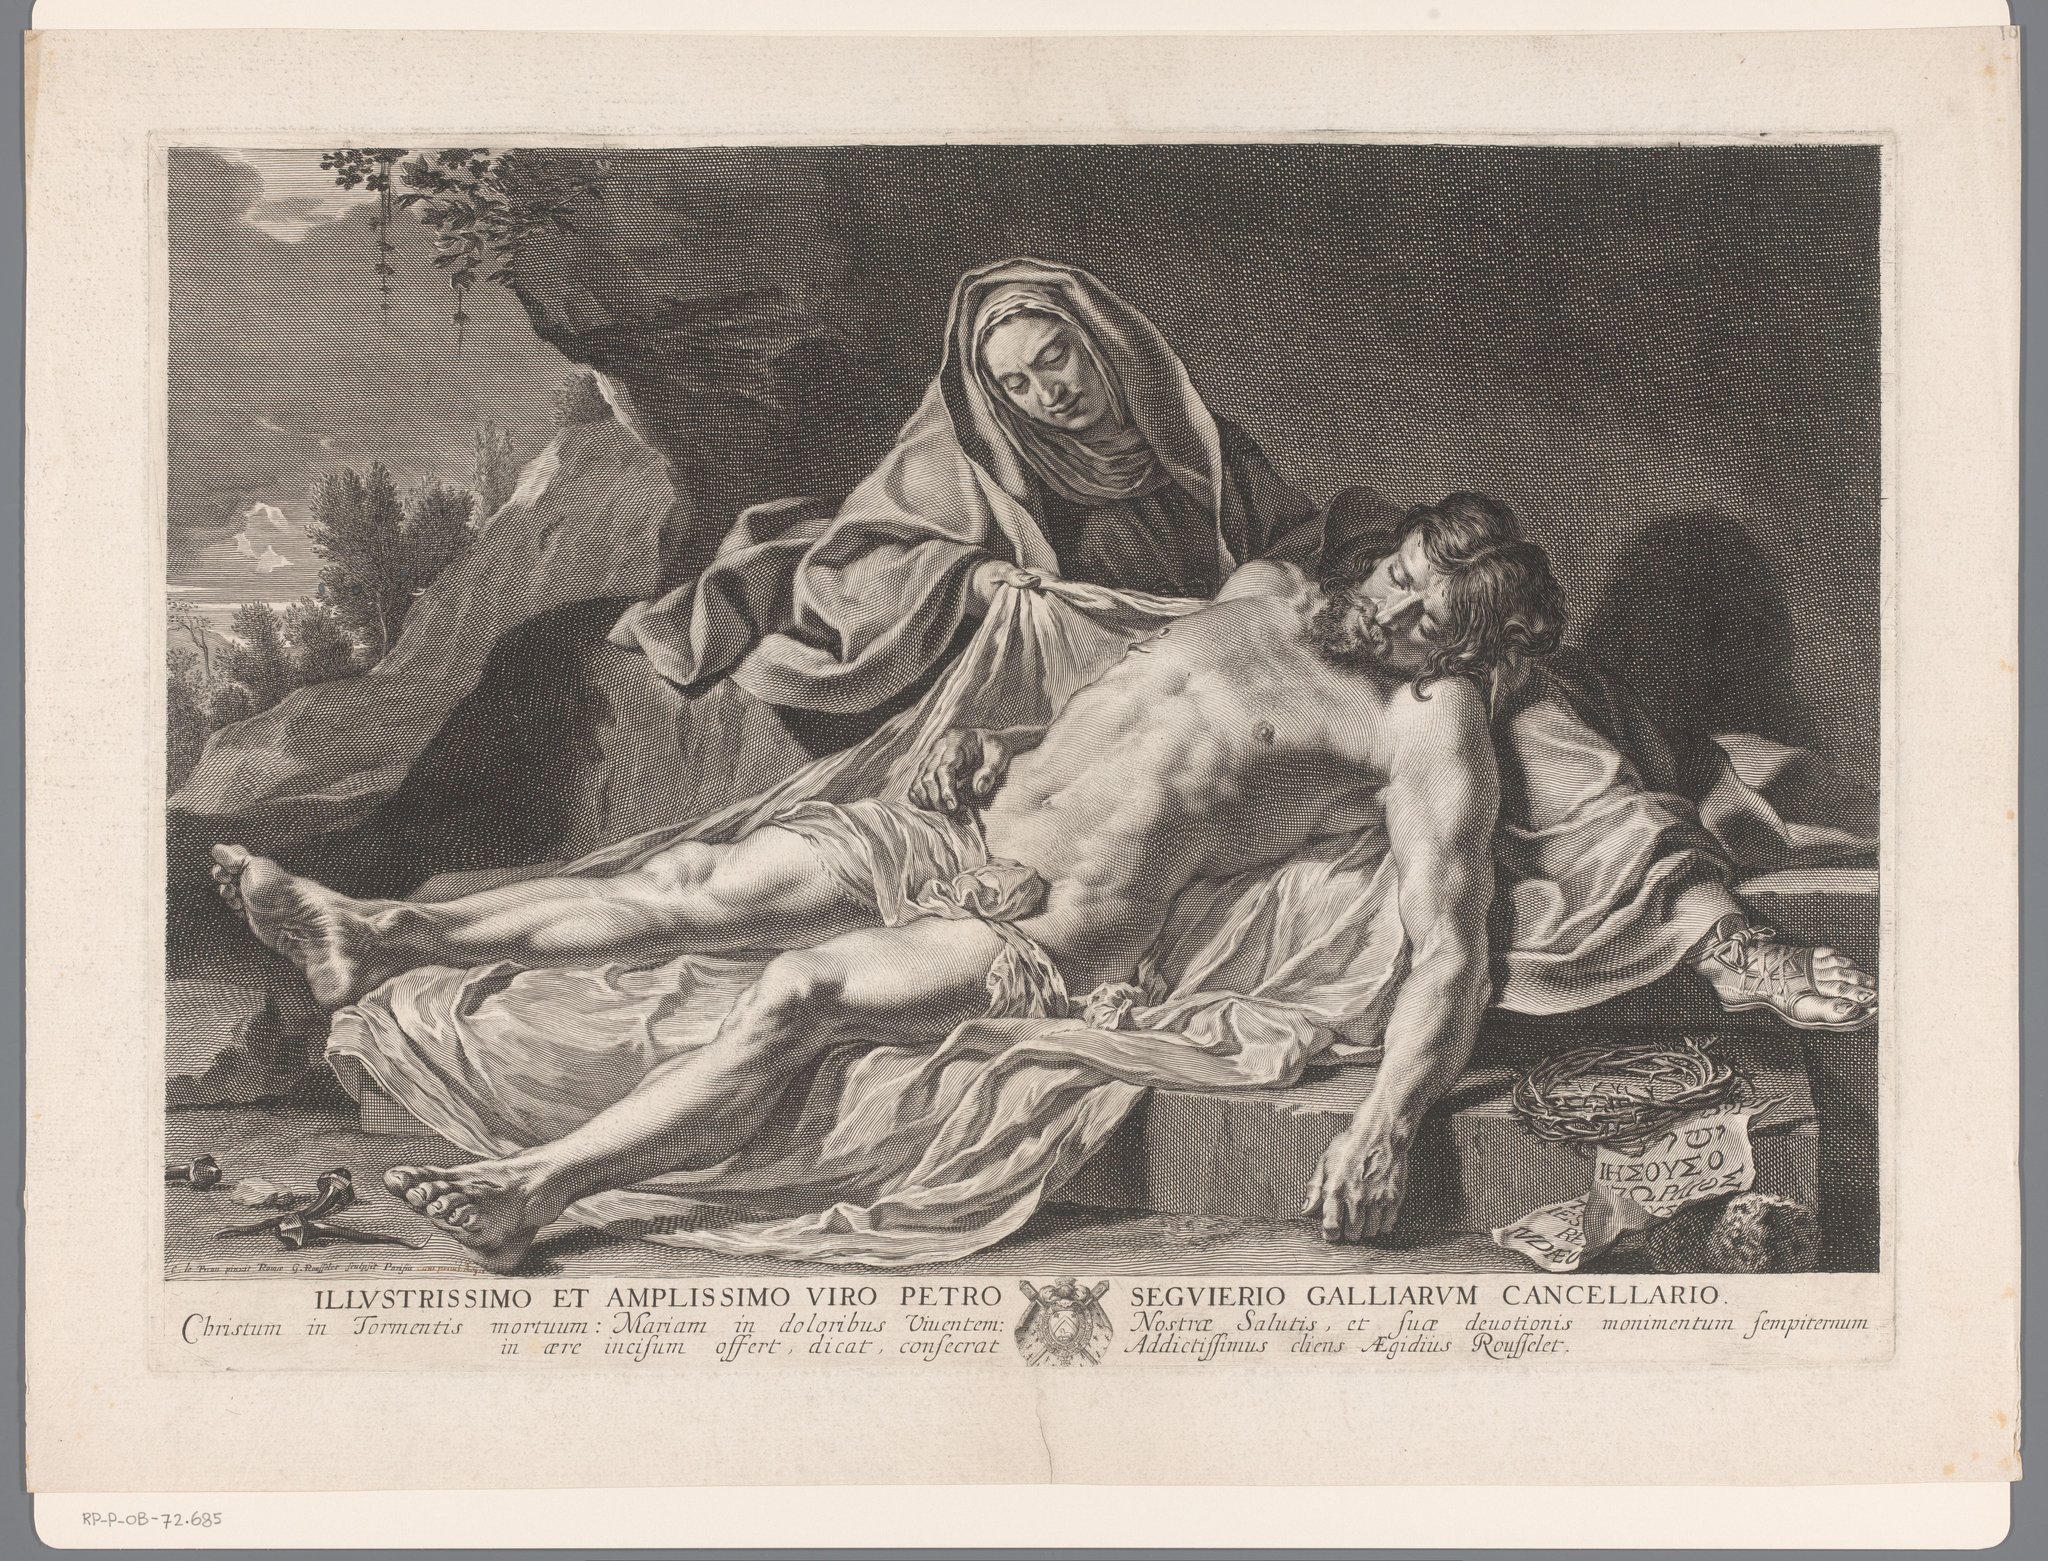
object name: print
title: Bewening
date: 1658-1660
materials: paper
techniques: engraving, etching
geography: paris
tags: lamentation over the dead christ by his relatives and friends (christ usually without crown of thorns)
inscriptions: collector's mark: Lugt 240